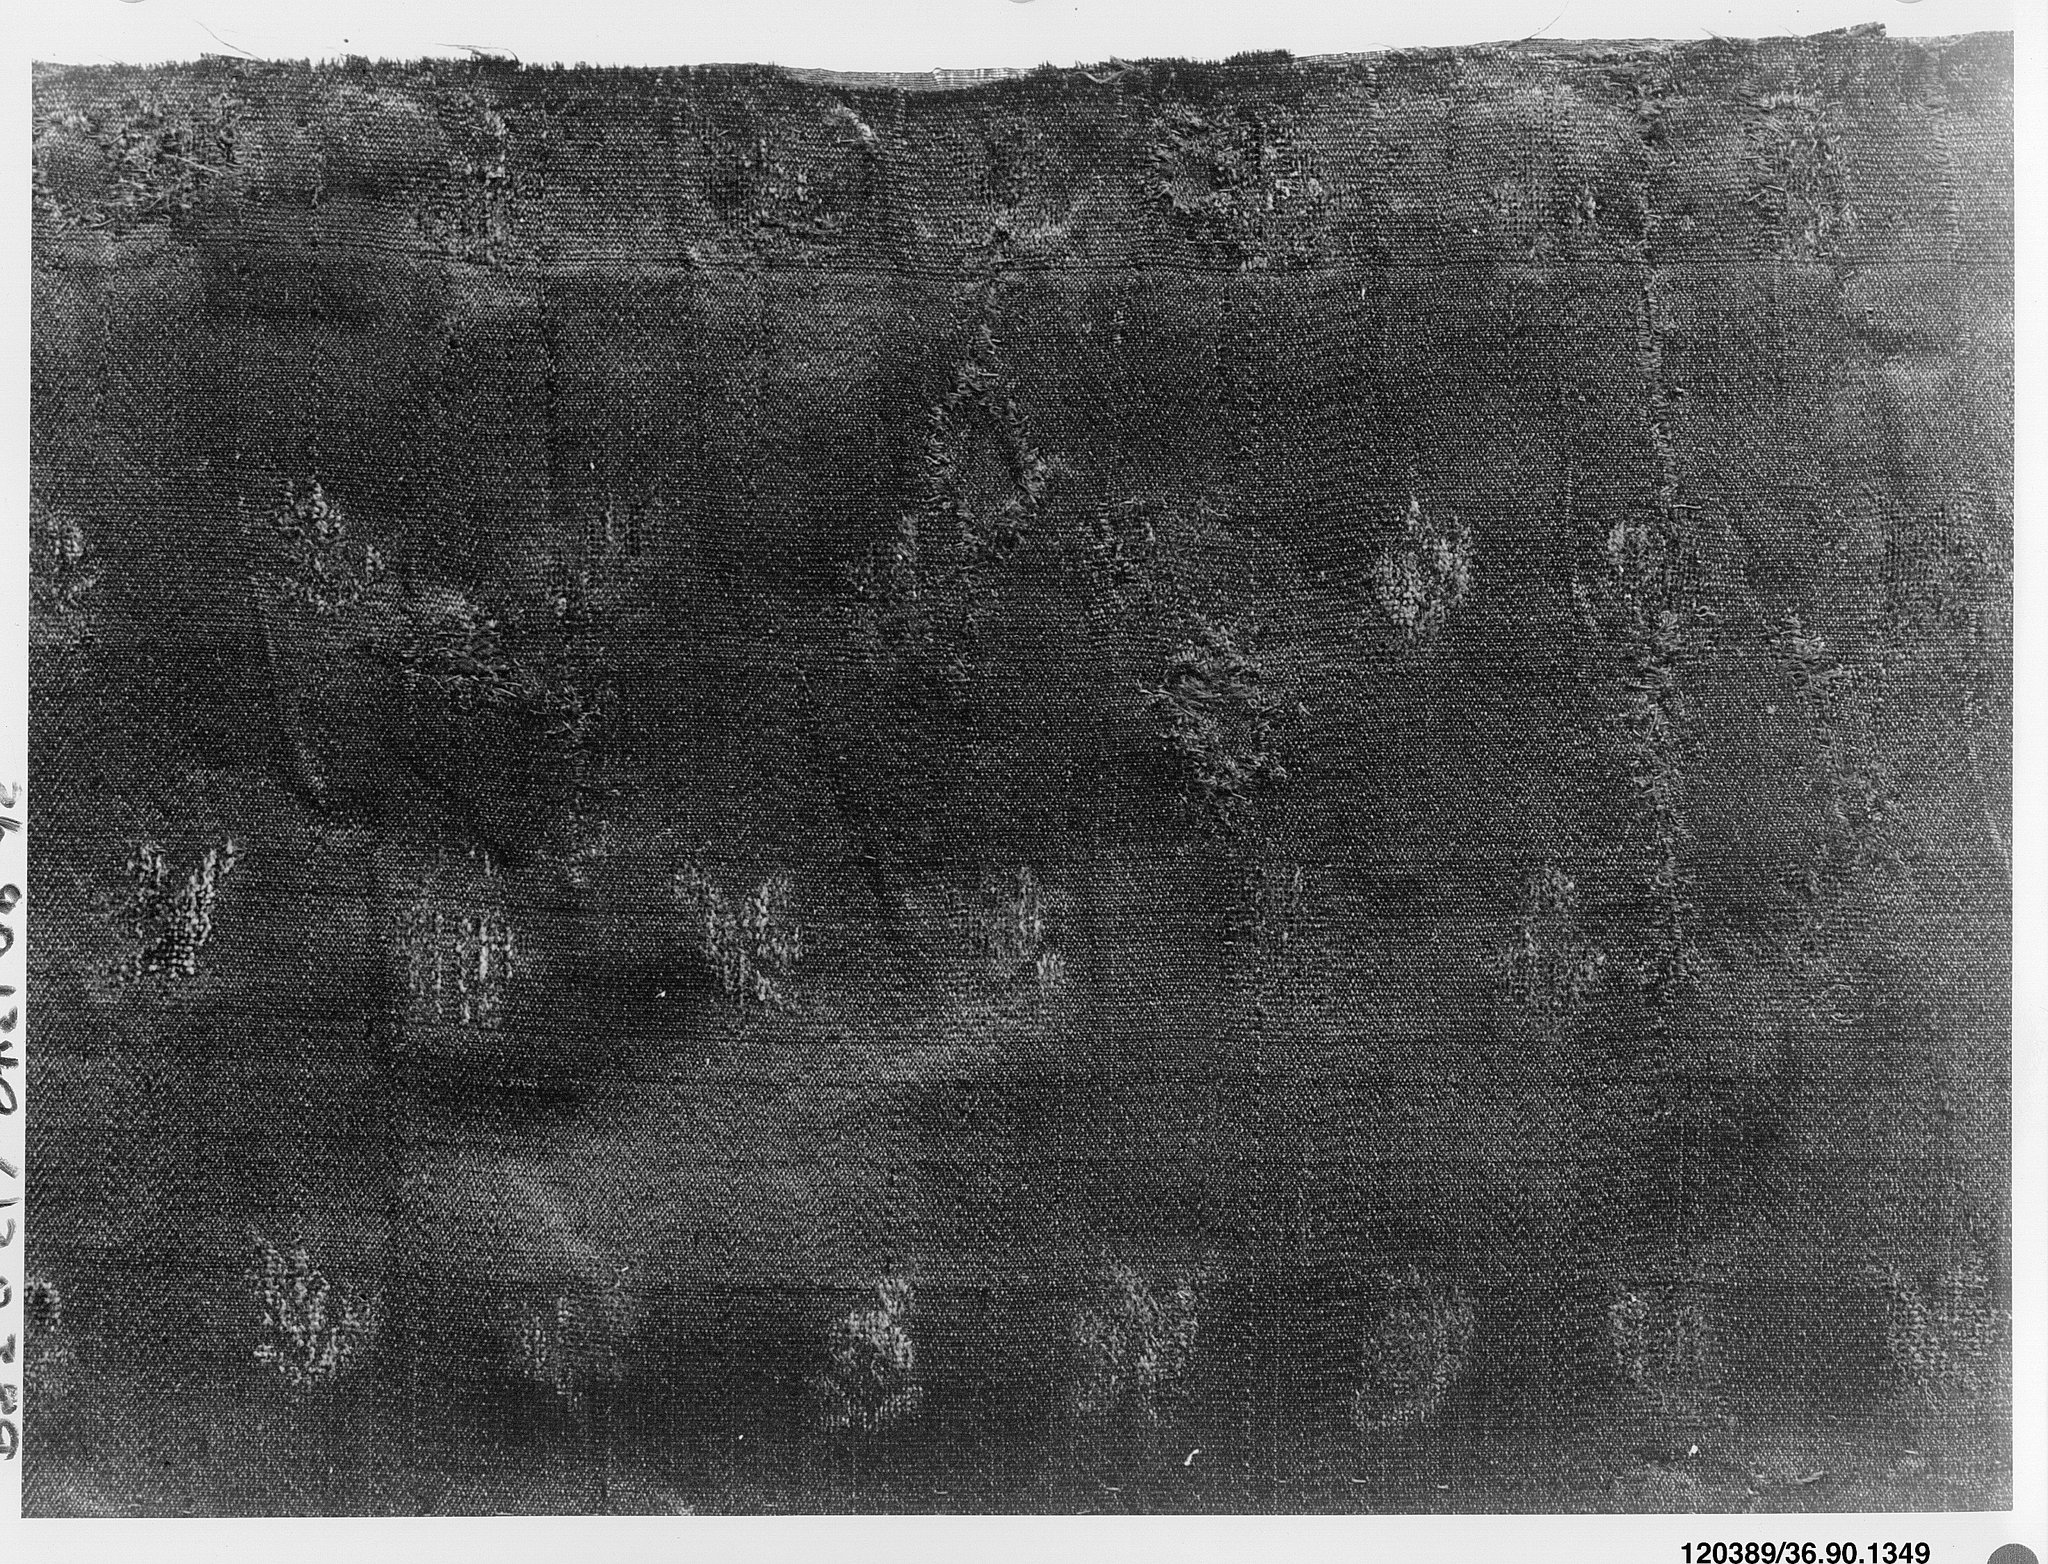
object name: piece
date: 1701-1800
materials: silk